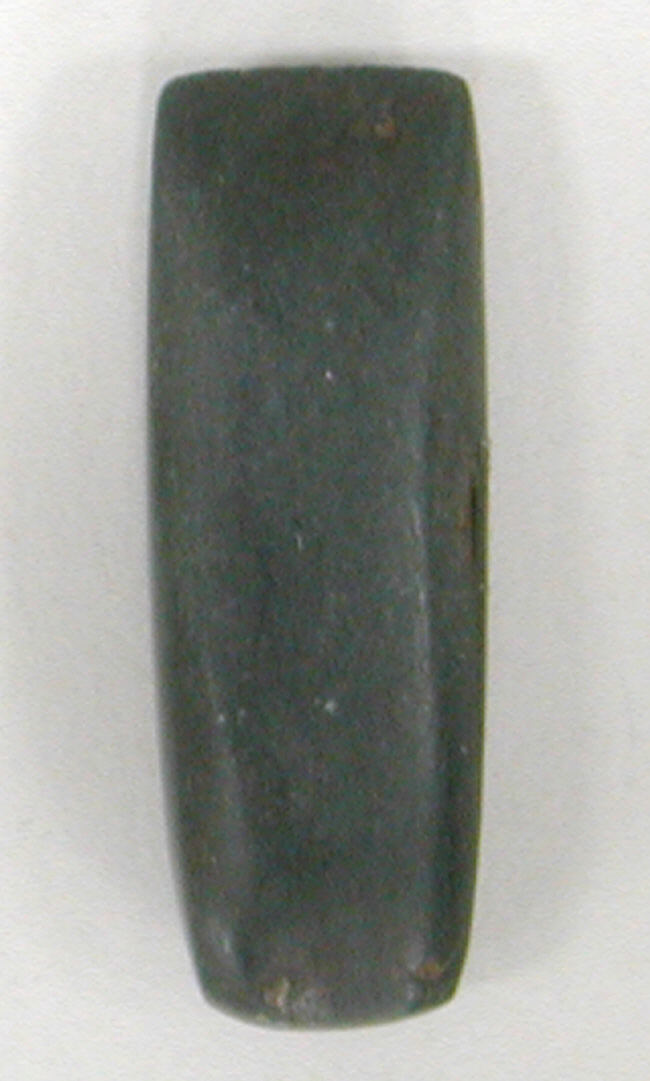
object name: celt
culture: maya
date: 1501-1600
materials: stone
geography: guatemala